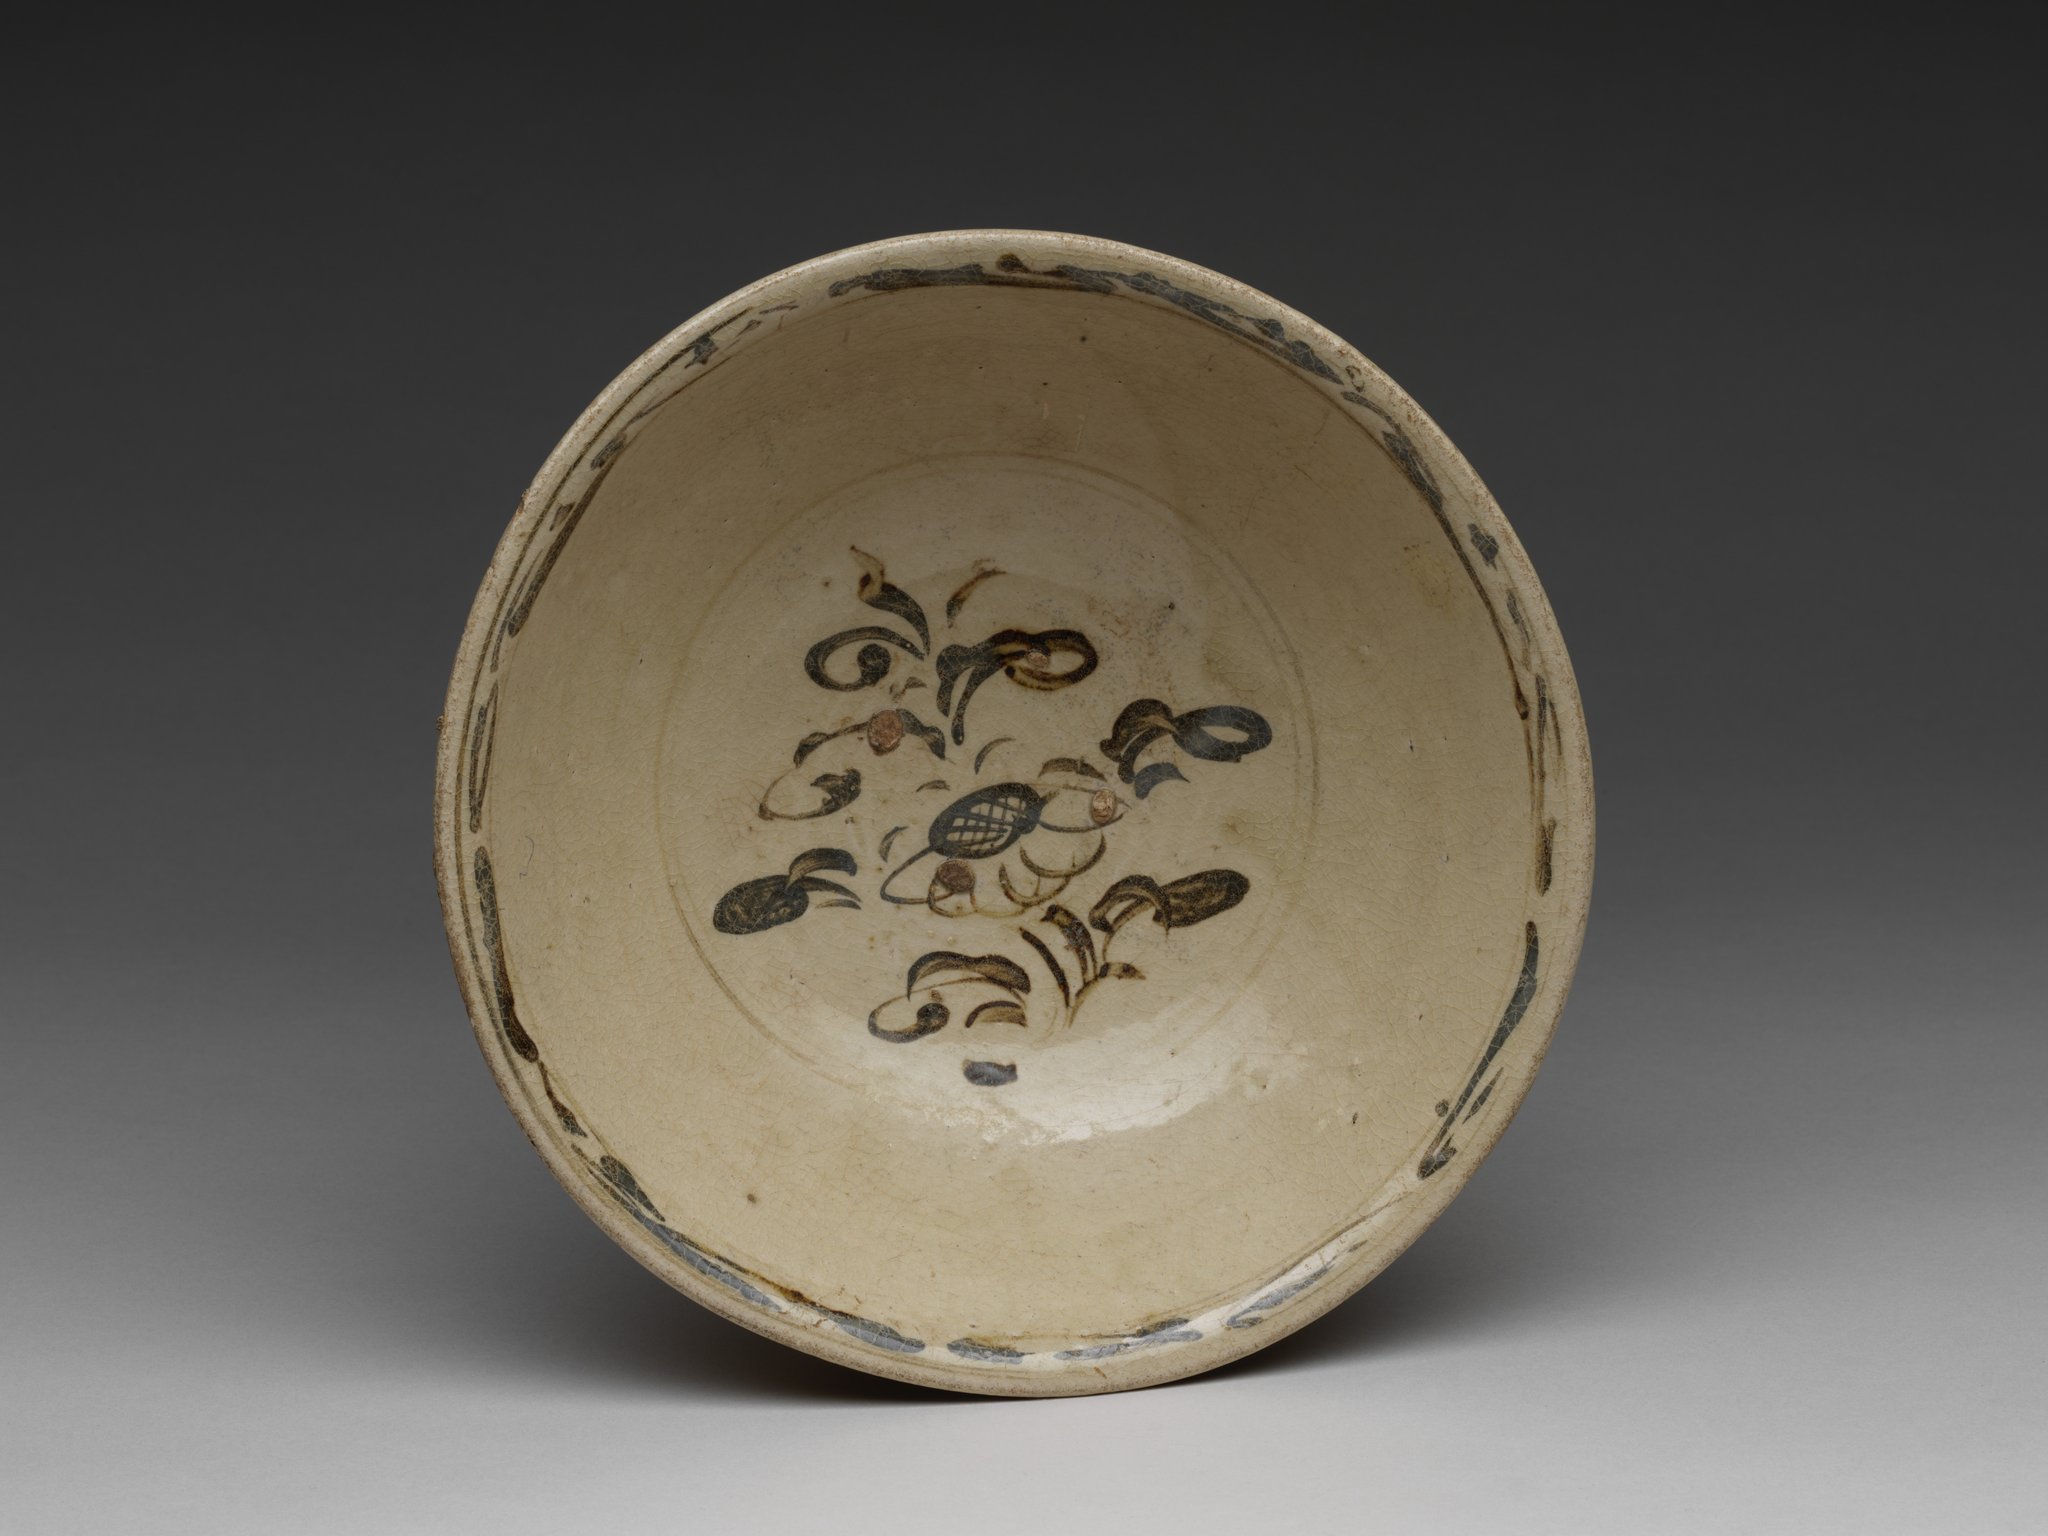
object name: bowl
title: Bowl with iron-brown floral décor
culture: vietnamese, hong river region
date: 1301-1433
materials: iron, stoneware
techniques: underglaze